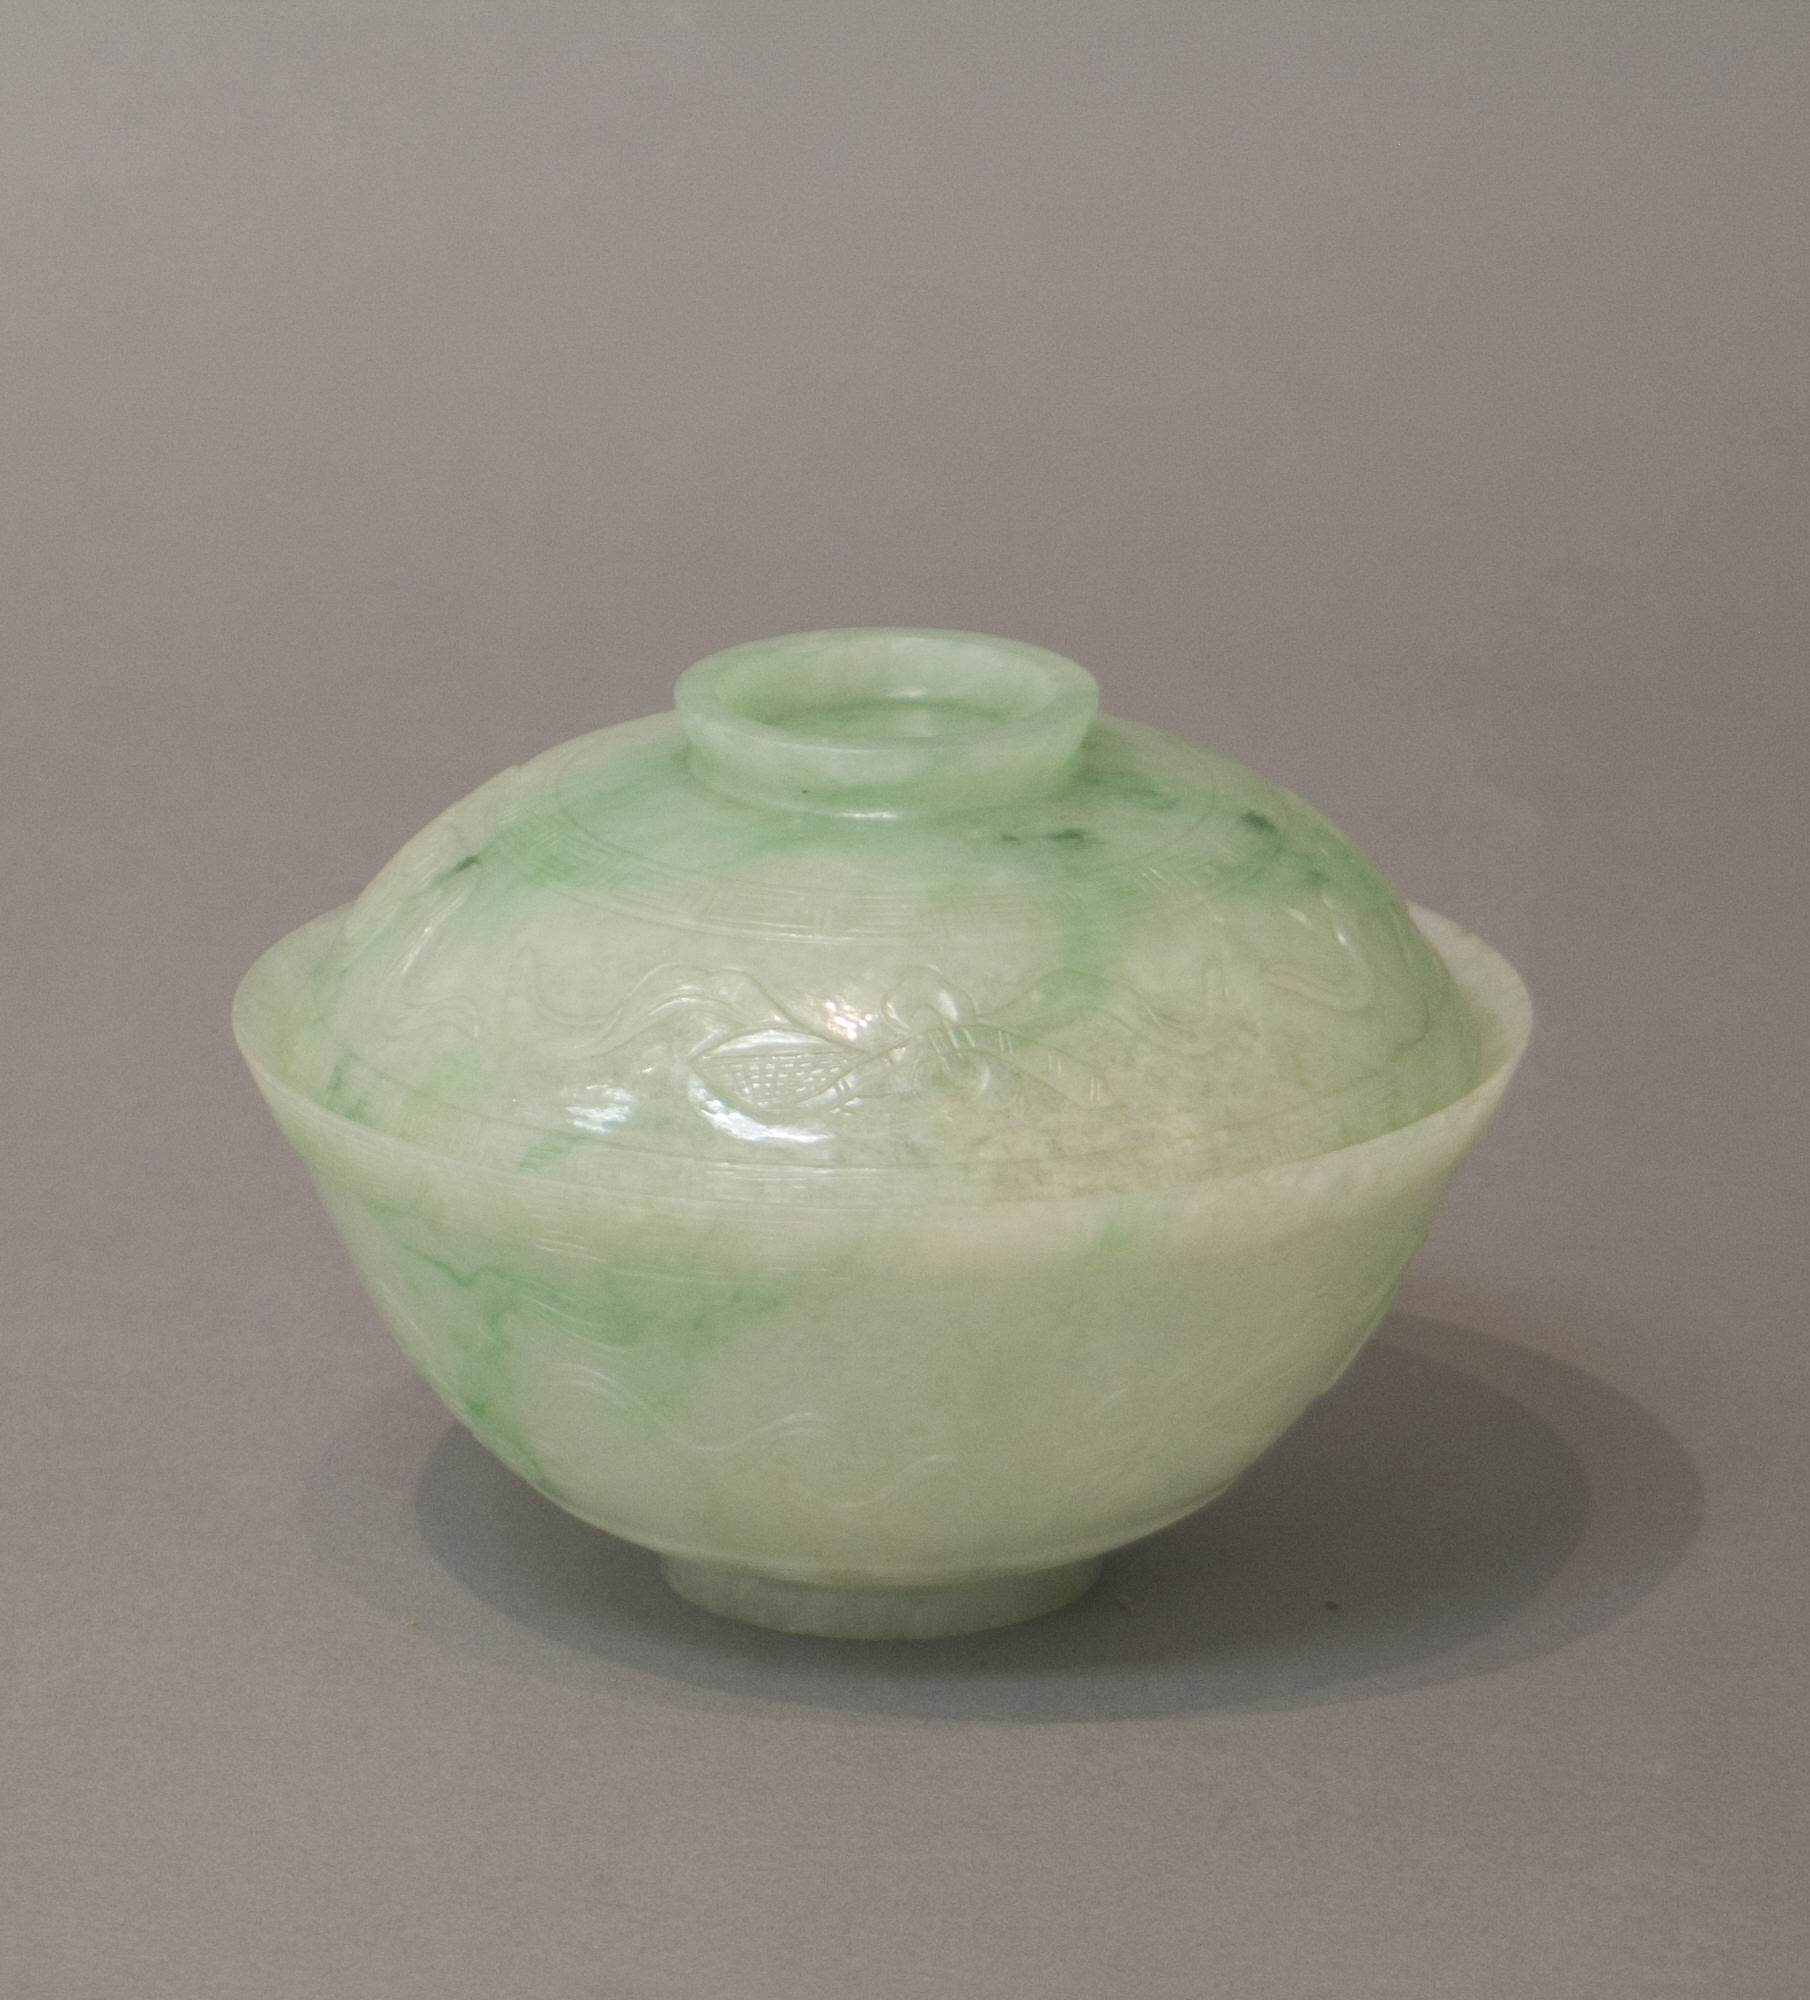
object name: cup with cover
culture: chinese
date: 1736-1795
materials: gemstone, jade